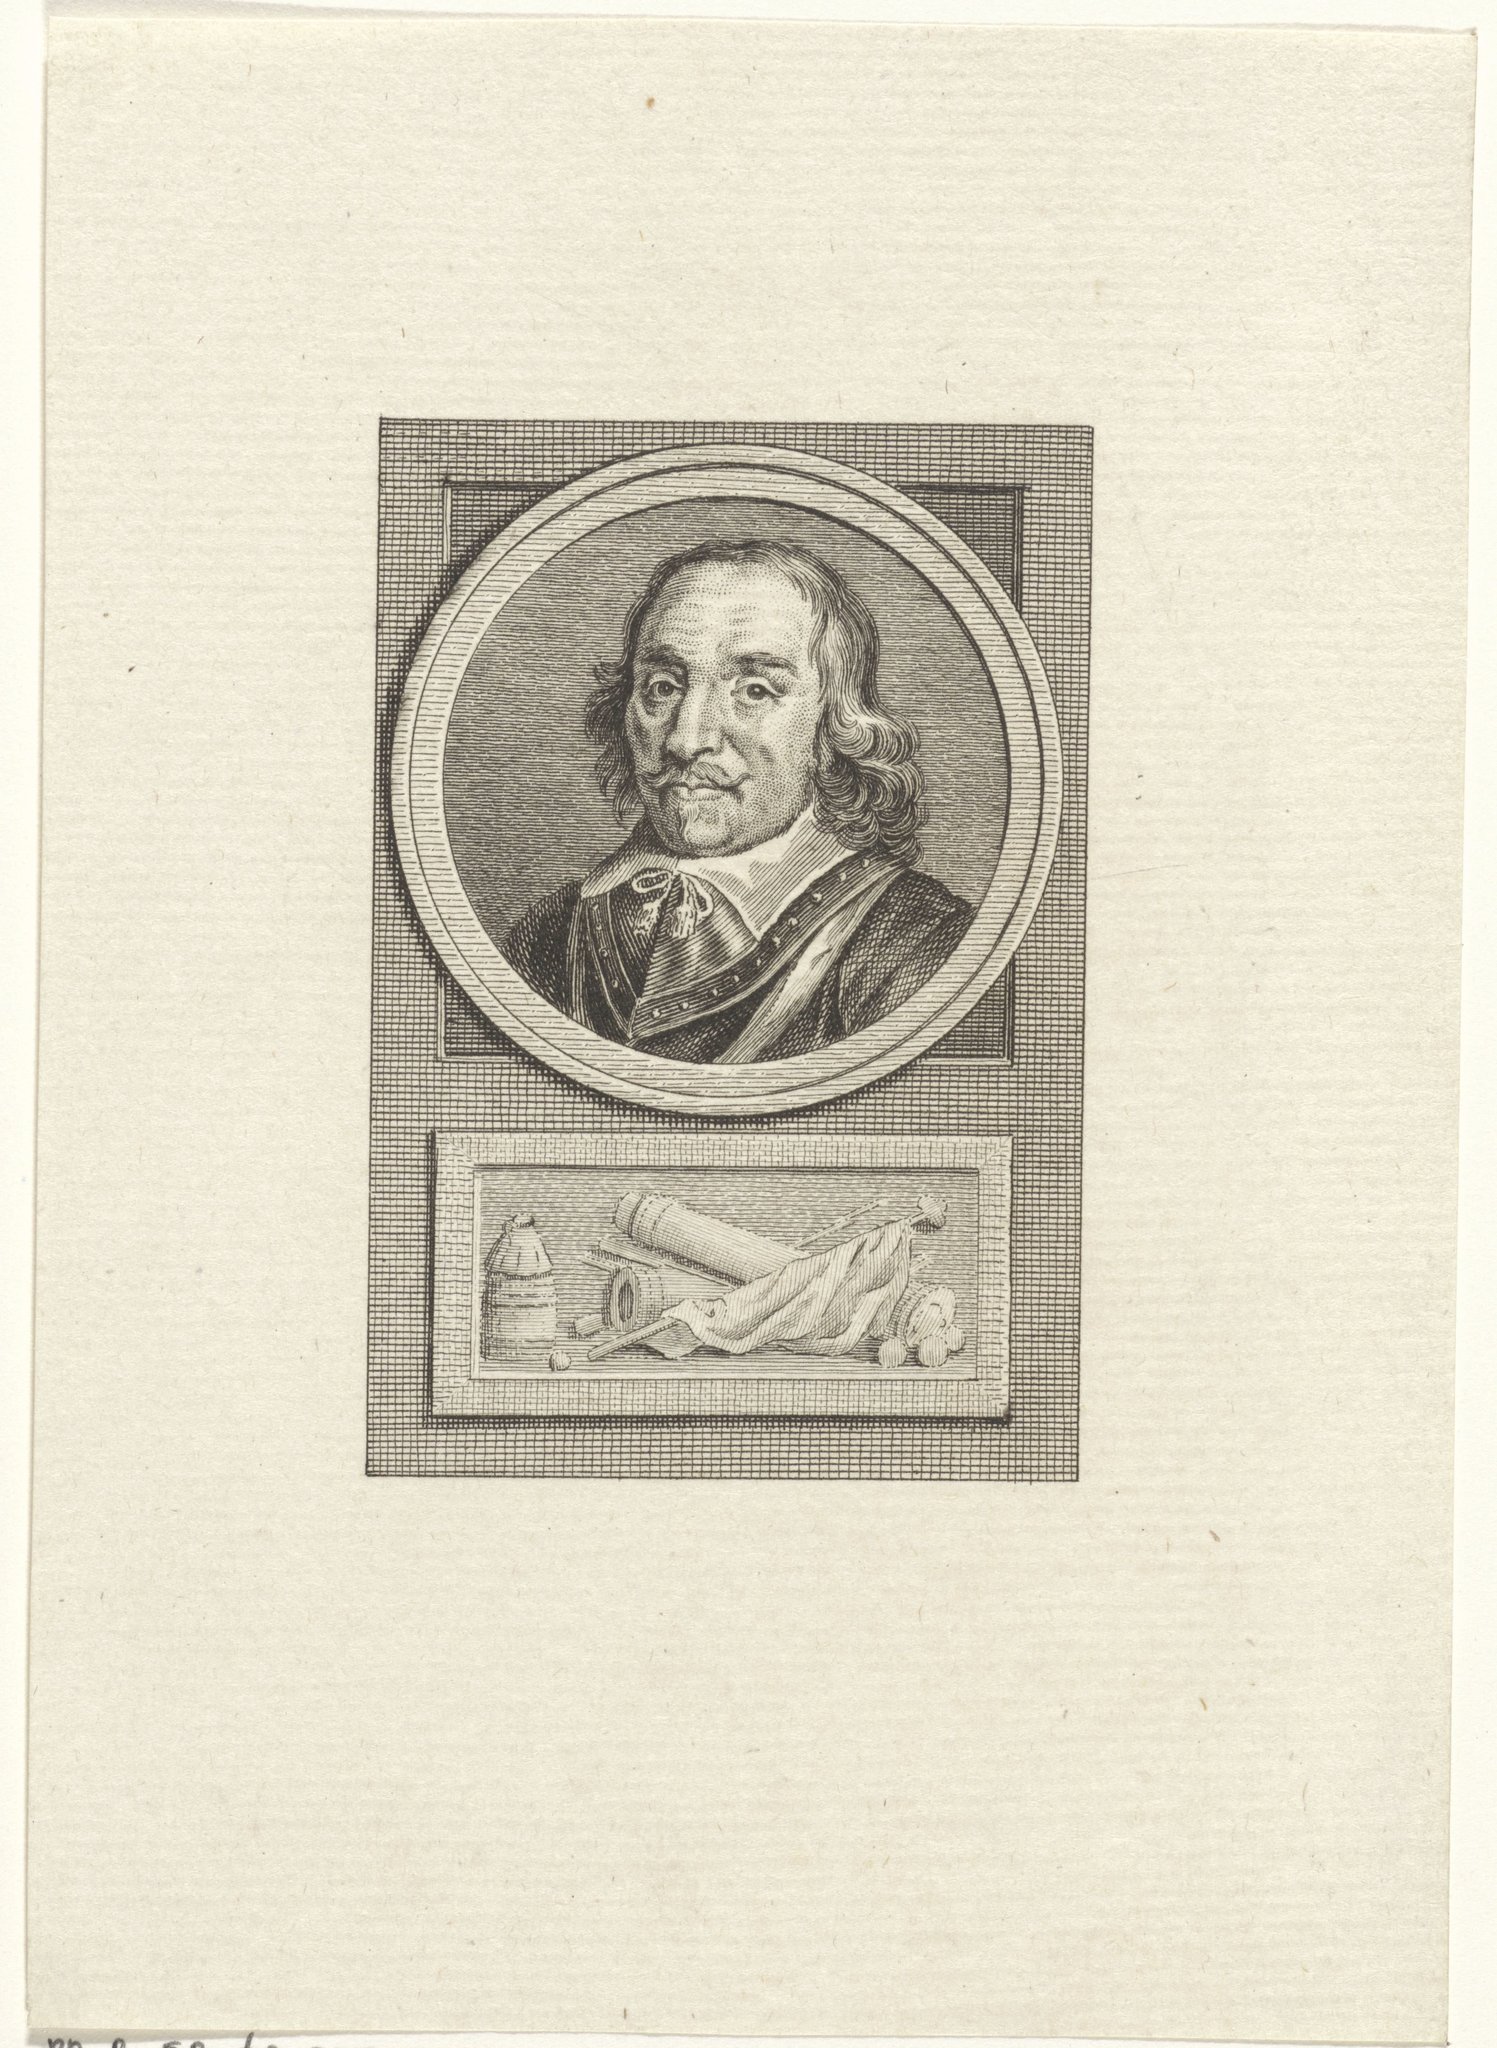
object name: print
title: Portret van Marten Harpertsz Tromp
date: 1783-1795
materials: paper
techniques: engraving, etching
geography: amsterdam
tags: brielle, maarten harpertszoon tromp, firearms: cannon, (military) flags and standards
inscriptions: collector's mark: Lugt 2228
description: Latere staat prent gebruikt in: Fokke, Jan. Geschiedenissen der Vereenigde Nederlanden voor de vaderlandsche jeugd Ie-XXVste deel. Amsterdam: Johannes Allart, 1783-1795. Deel IX.